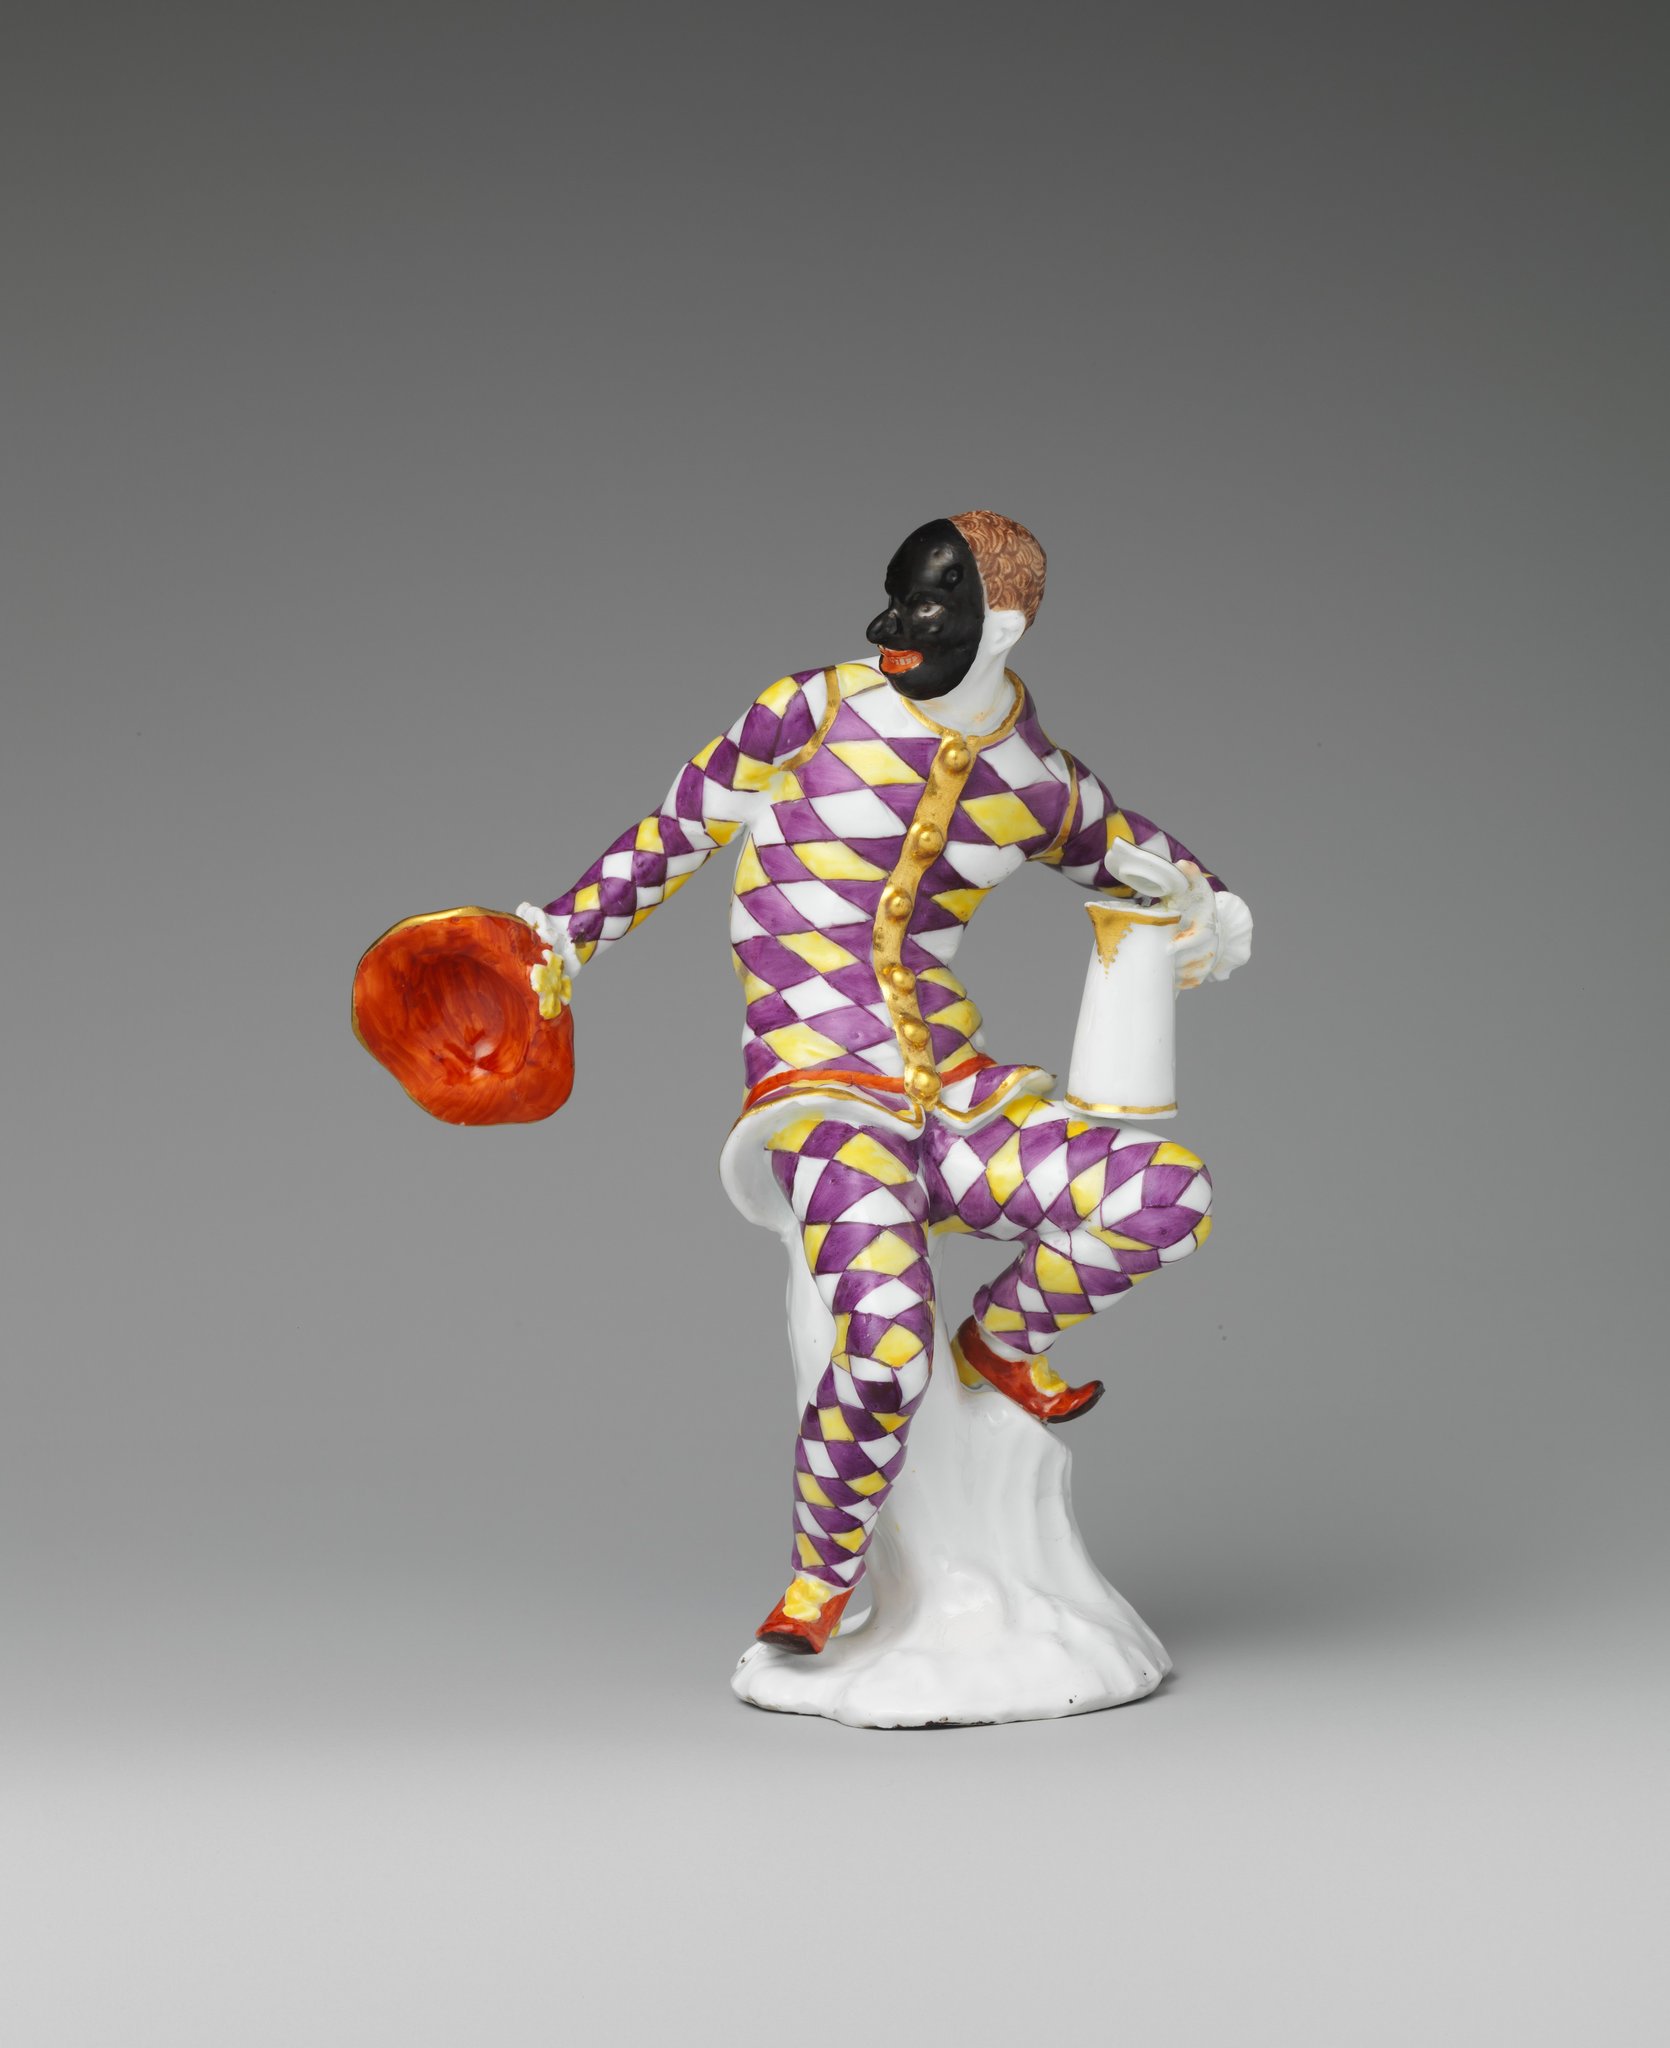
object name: figure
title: Harlequin with jug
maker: meissen manufactory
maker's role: manufactory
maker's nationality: german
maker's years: 1710-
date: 1740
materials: enamel, gold, hard paste porcelain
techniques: polychrome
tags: men